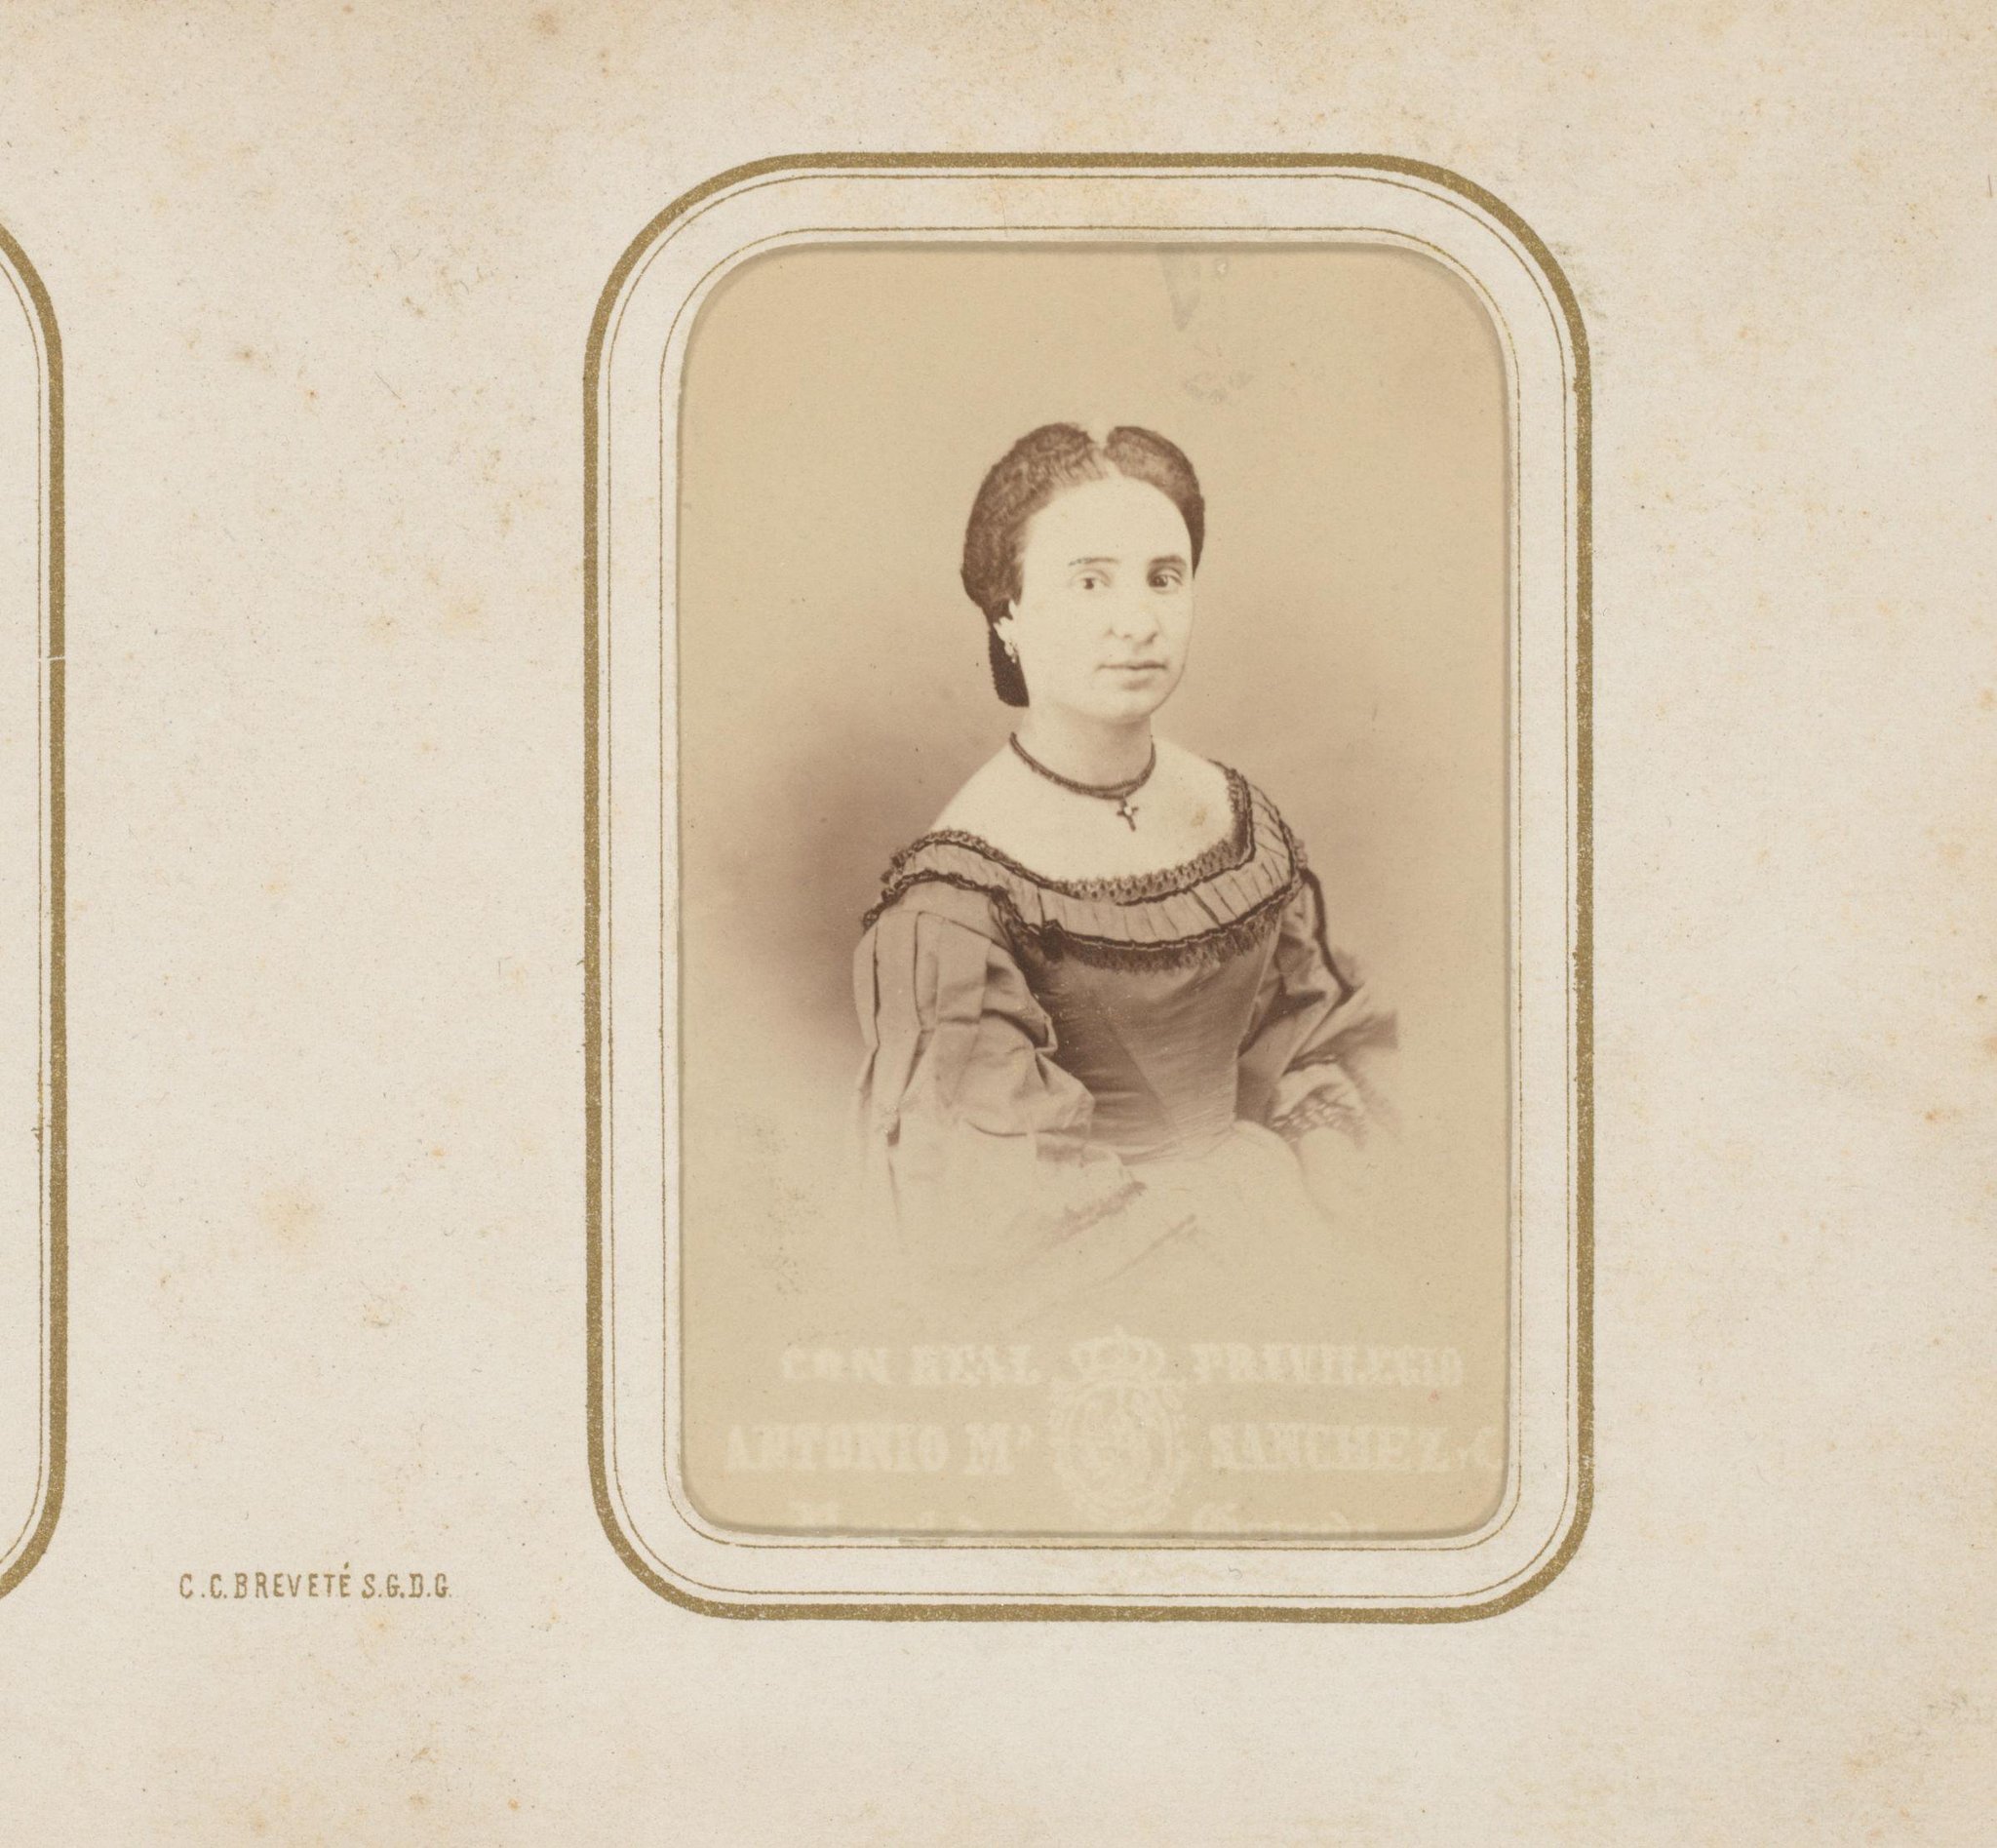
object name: photograph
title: Portret van een vrouw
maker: antonio sanchez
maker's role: fotograaf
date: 1860-1900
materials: cardboard, photographic support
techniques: albumen print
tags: sitting figure, adult woman, historical persons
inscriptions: annotation: ‘[...]umia’, inscription: ‘Litografia/ y Fotografia/ de/ A. Sanchez/ (...)/ Carrera de Genil No. 41/ Granada’